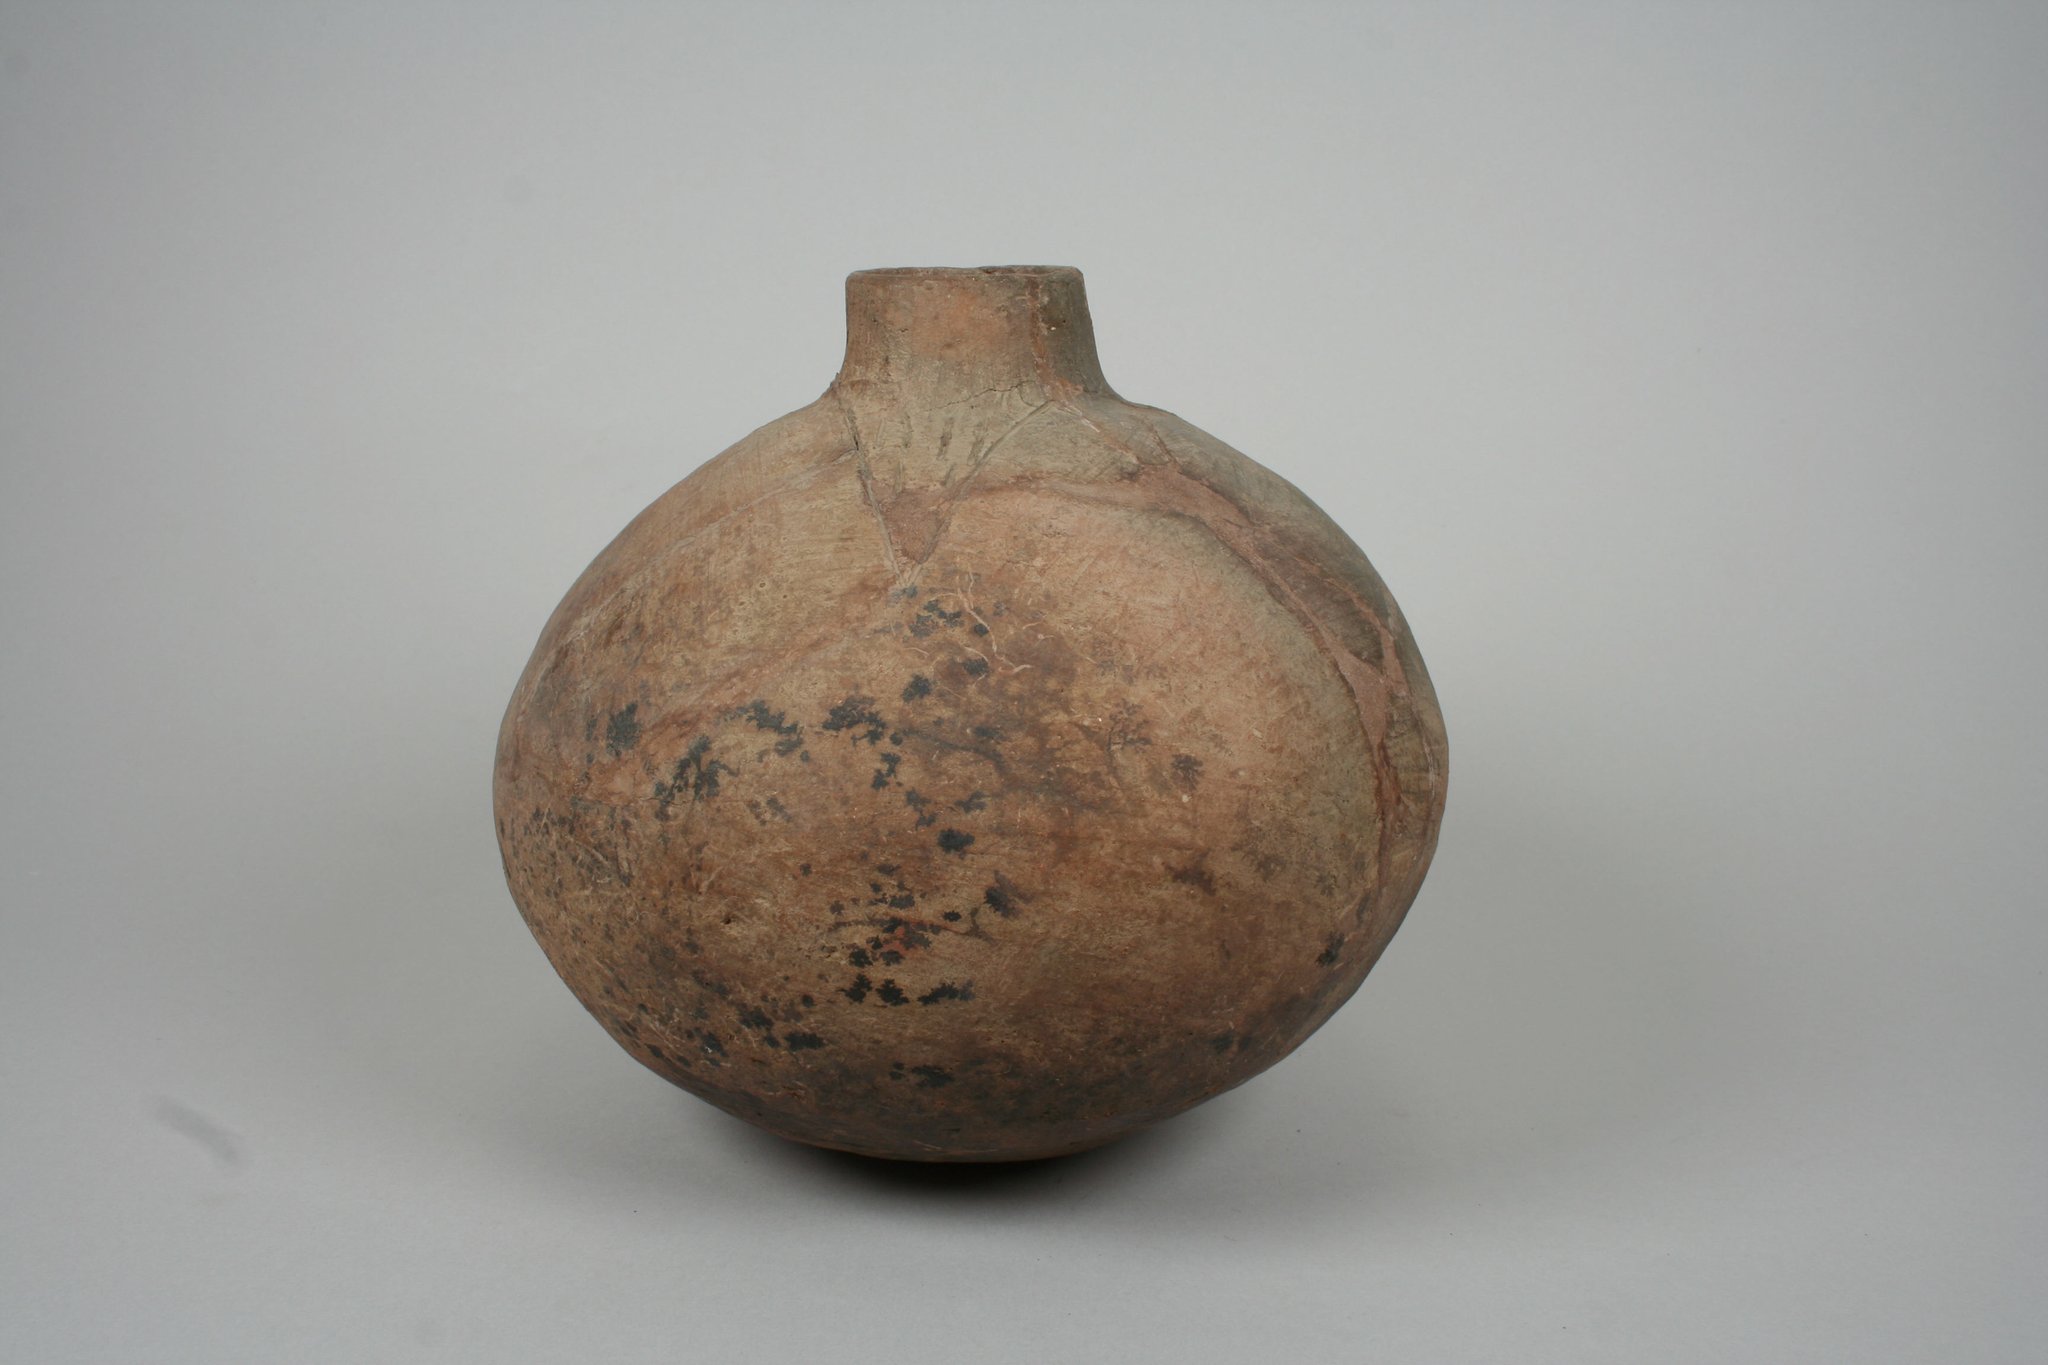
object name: jar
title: Storage jar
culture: paracas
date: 300-101 BCE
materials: ceramic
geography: peru